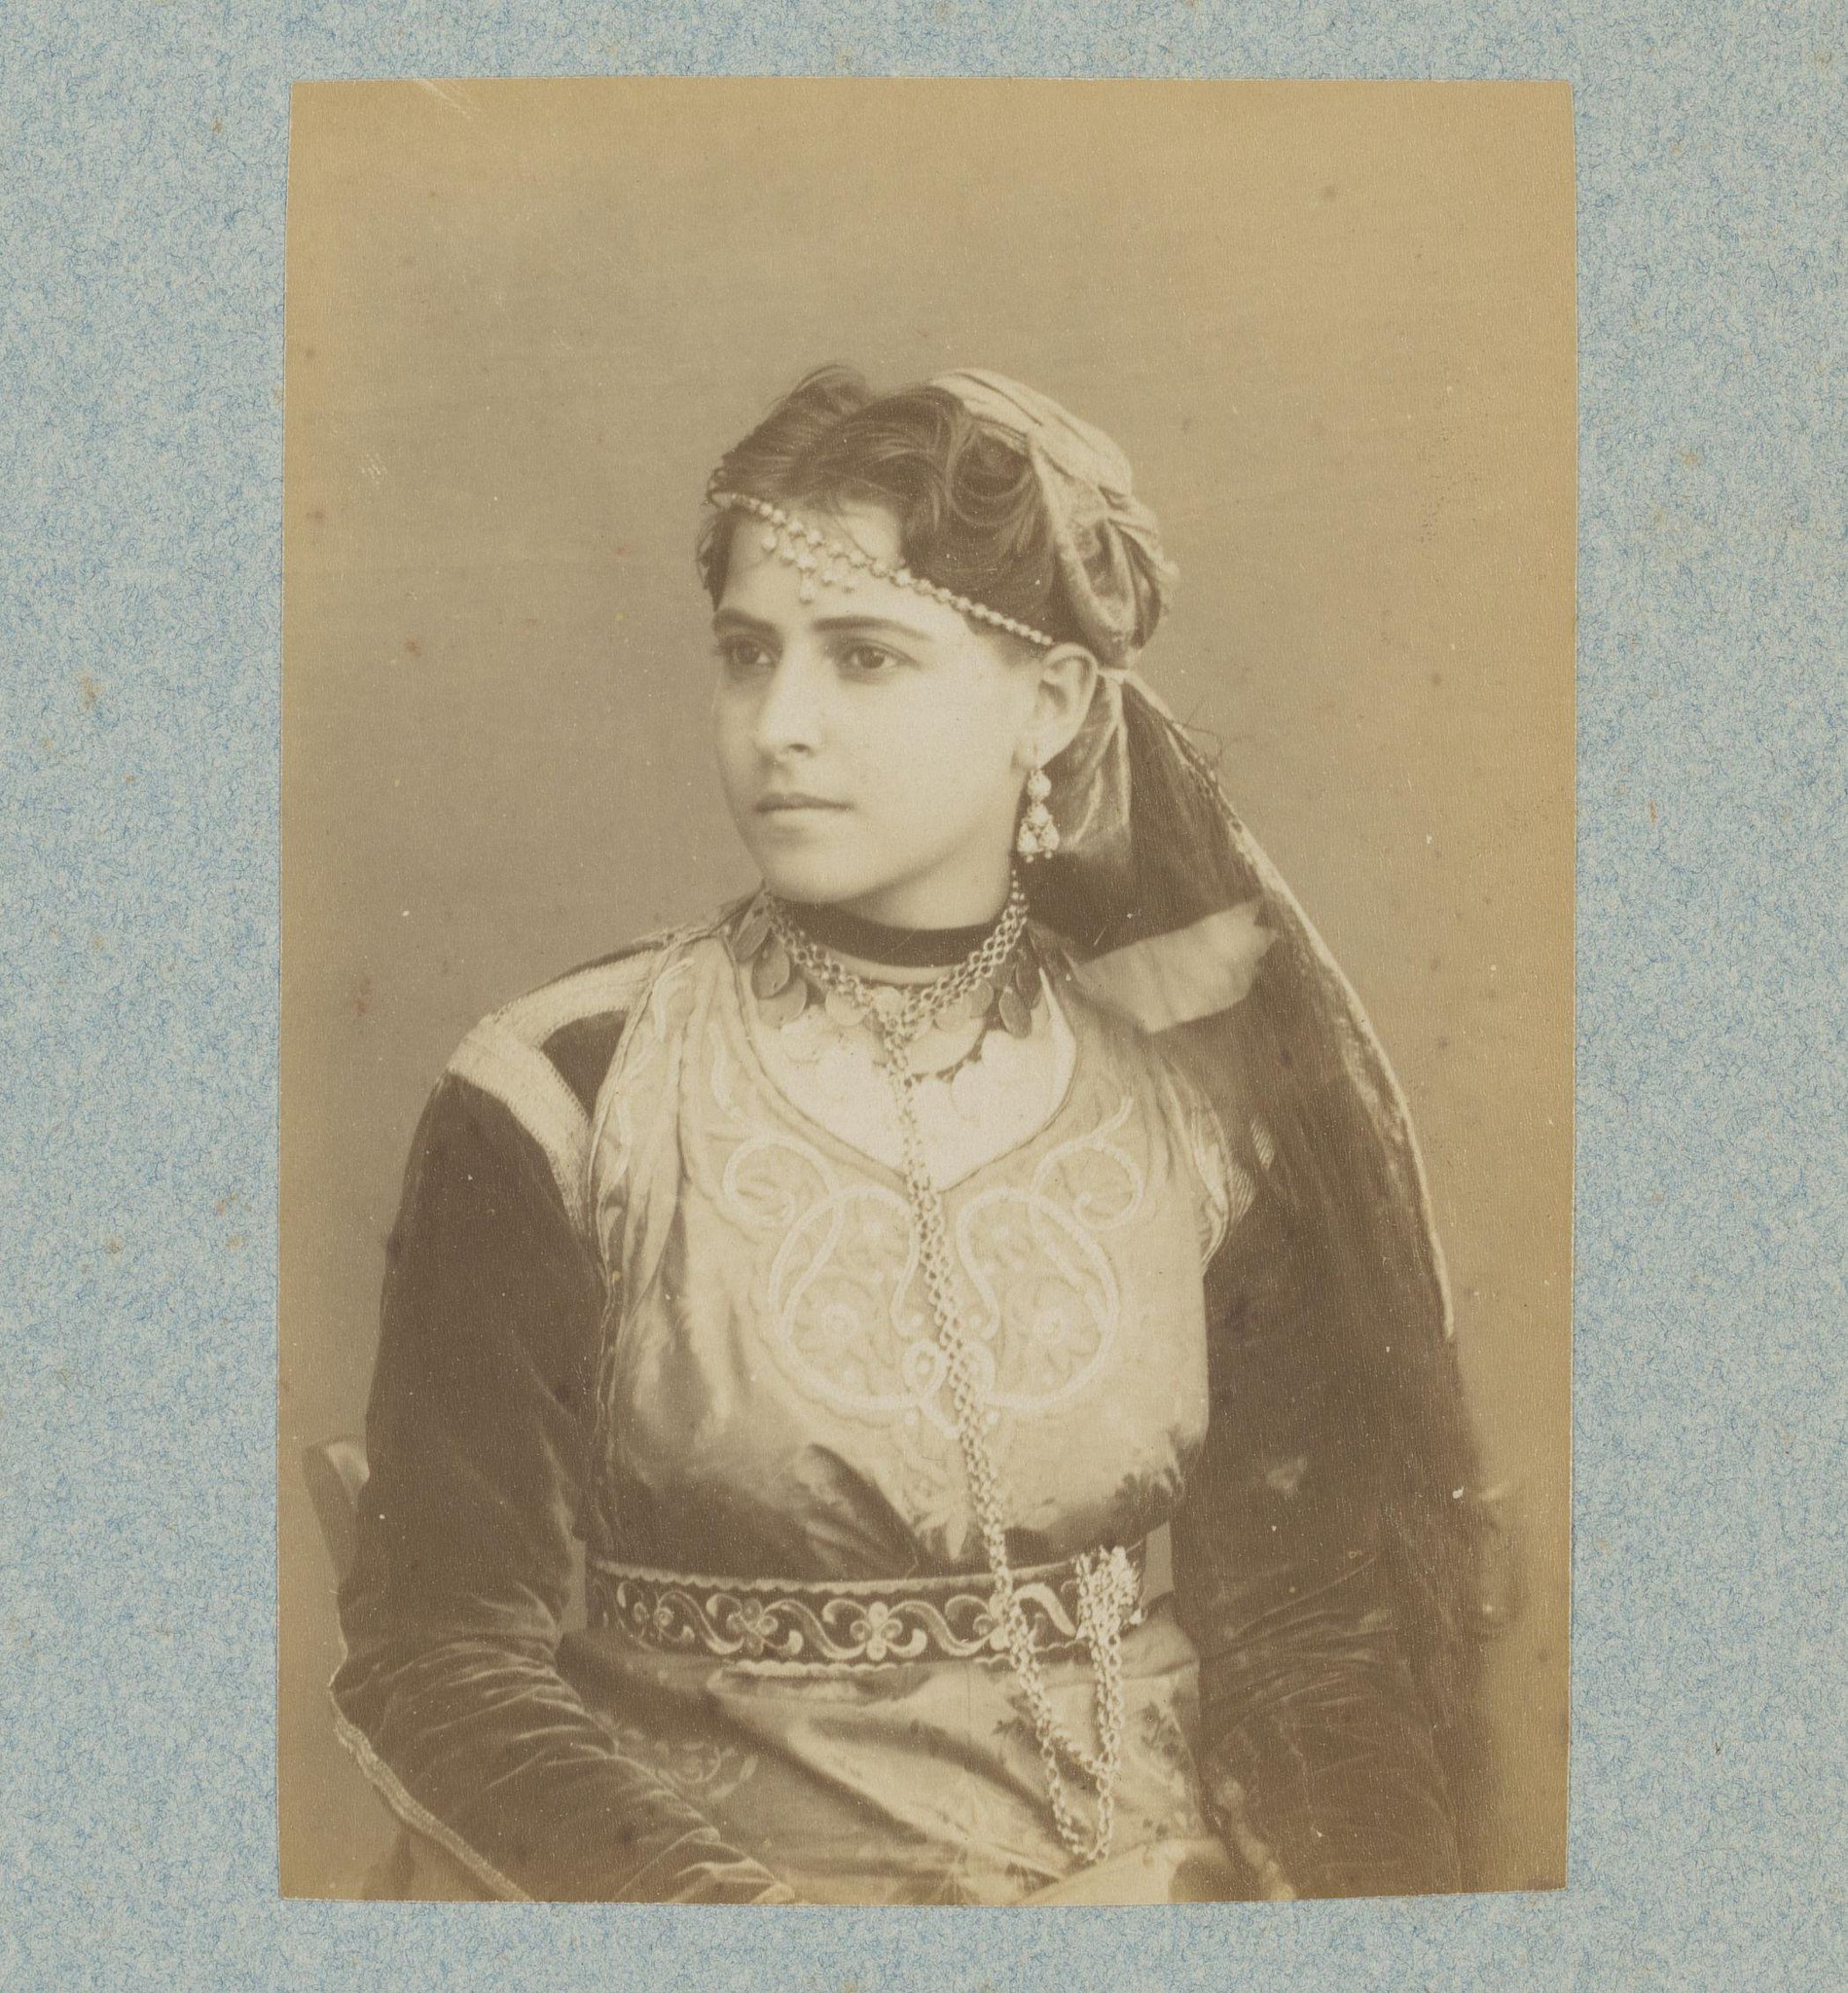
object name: photograph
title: Portret van een onbekende Algerijnse vrouw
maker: Anonymous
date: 1851-1900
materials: cardboard, paper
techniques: albumen print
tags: anonymous historical person portrayed - bb - woman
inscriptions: inscription: ‘Algiers’, inscription: ‘d'Alger’, collector's mark: ‘VOSMAER’, inscription: ‘[...]’